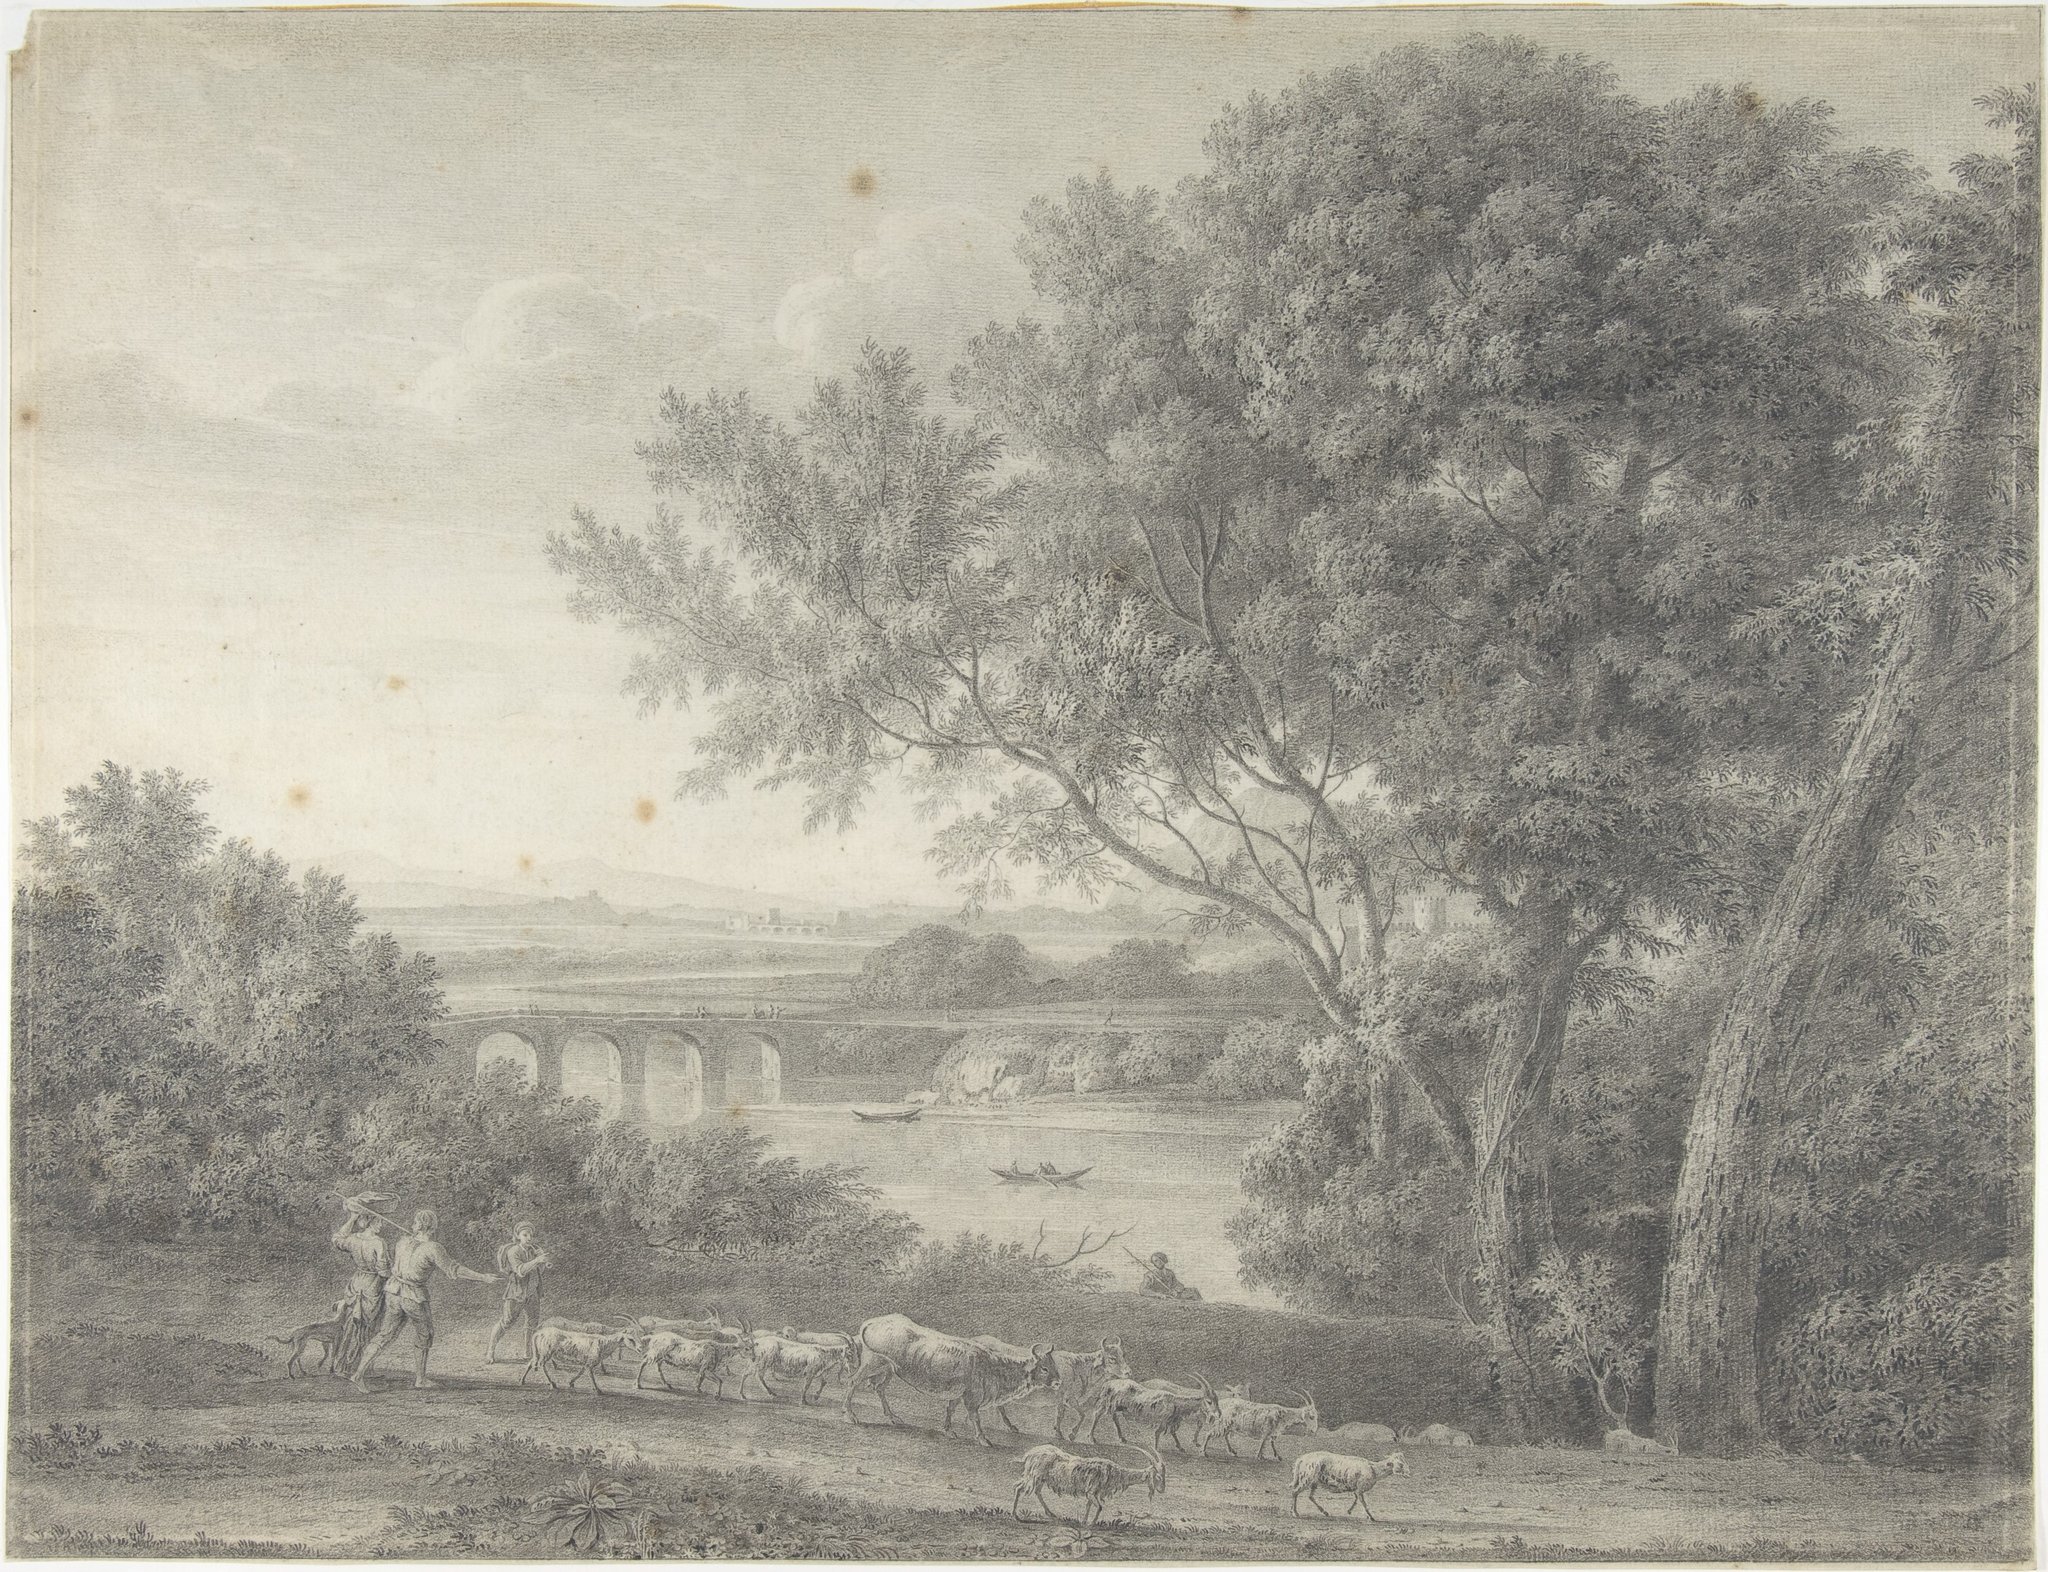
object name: drawing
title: Classical Landscape with Herdsmen in the Foreground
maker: giovanni battista ("titta") lusieri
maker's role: artist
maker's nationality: italian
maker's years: 1754-1821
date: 1755-1821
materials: graphite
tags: bridges,men,cows,landscapes,trees